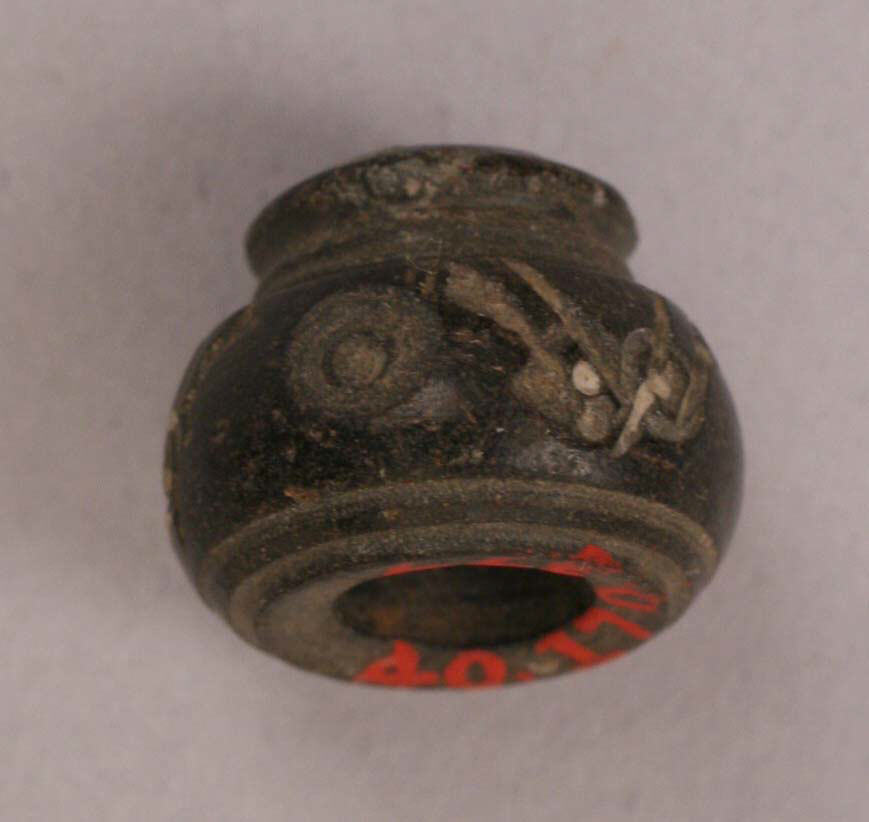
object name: button or bead or spindle whorl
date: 701-1300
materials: stone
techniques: carving, incising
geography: iran